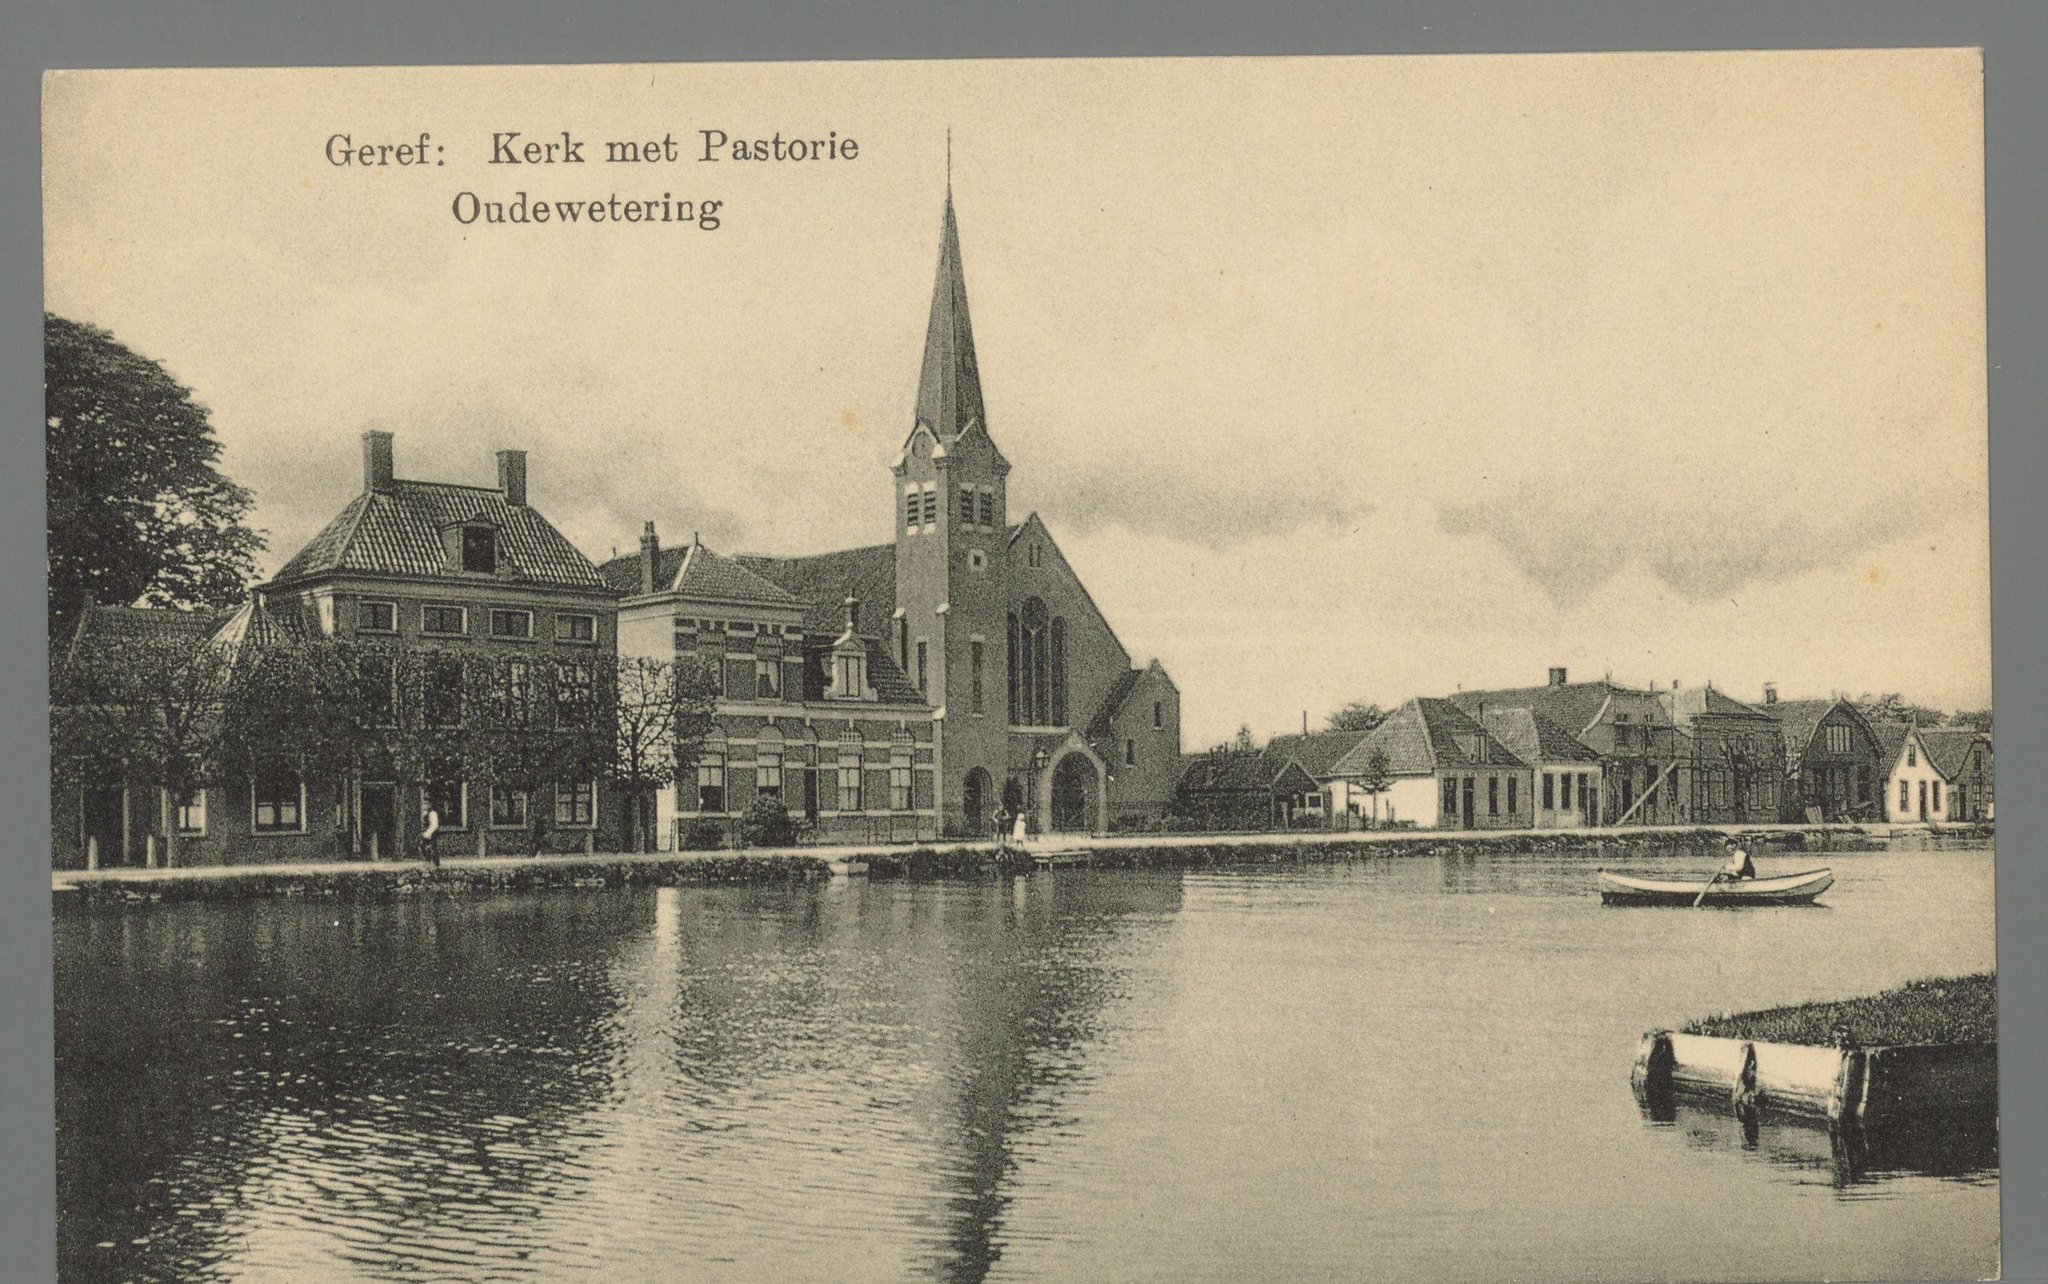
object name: photomechanical print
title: Geref: Kerk met pastorie. Oudewetering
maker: Anonymous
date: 1905-1930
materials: cardboard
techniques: photograph, writing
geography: oude wetering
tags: city-view, and landscape with man-made constructions, river, church (exterior)